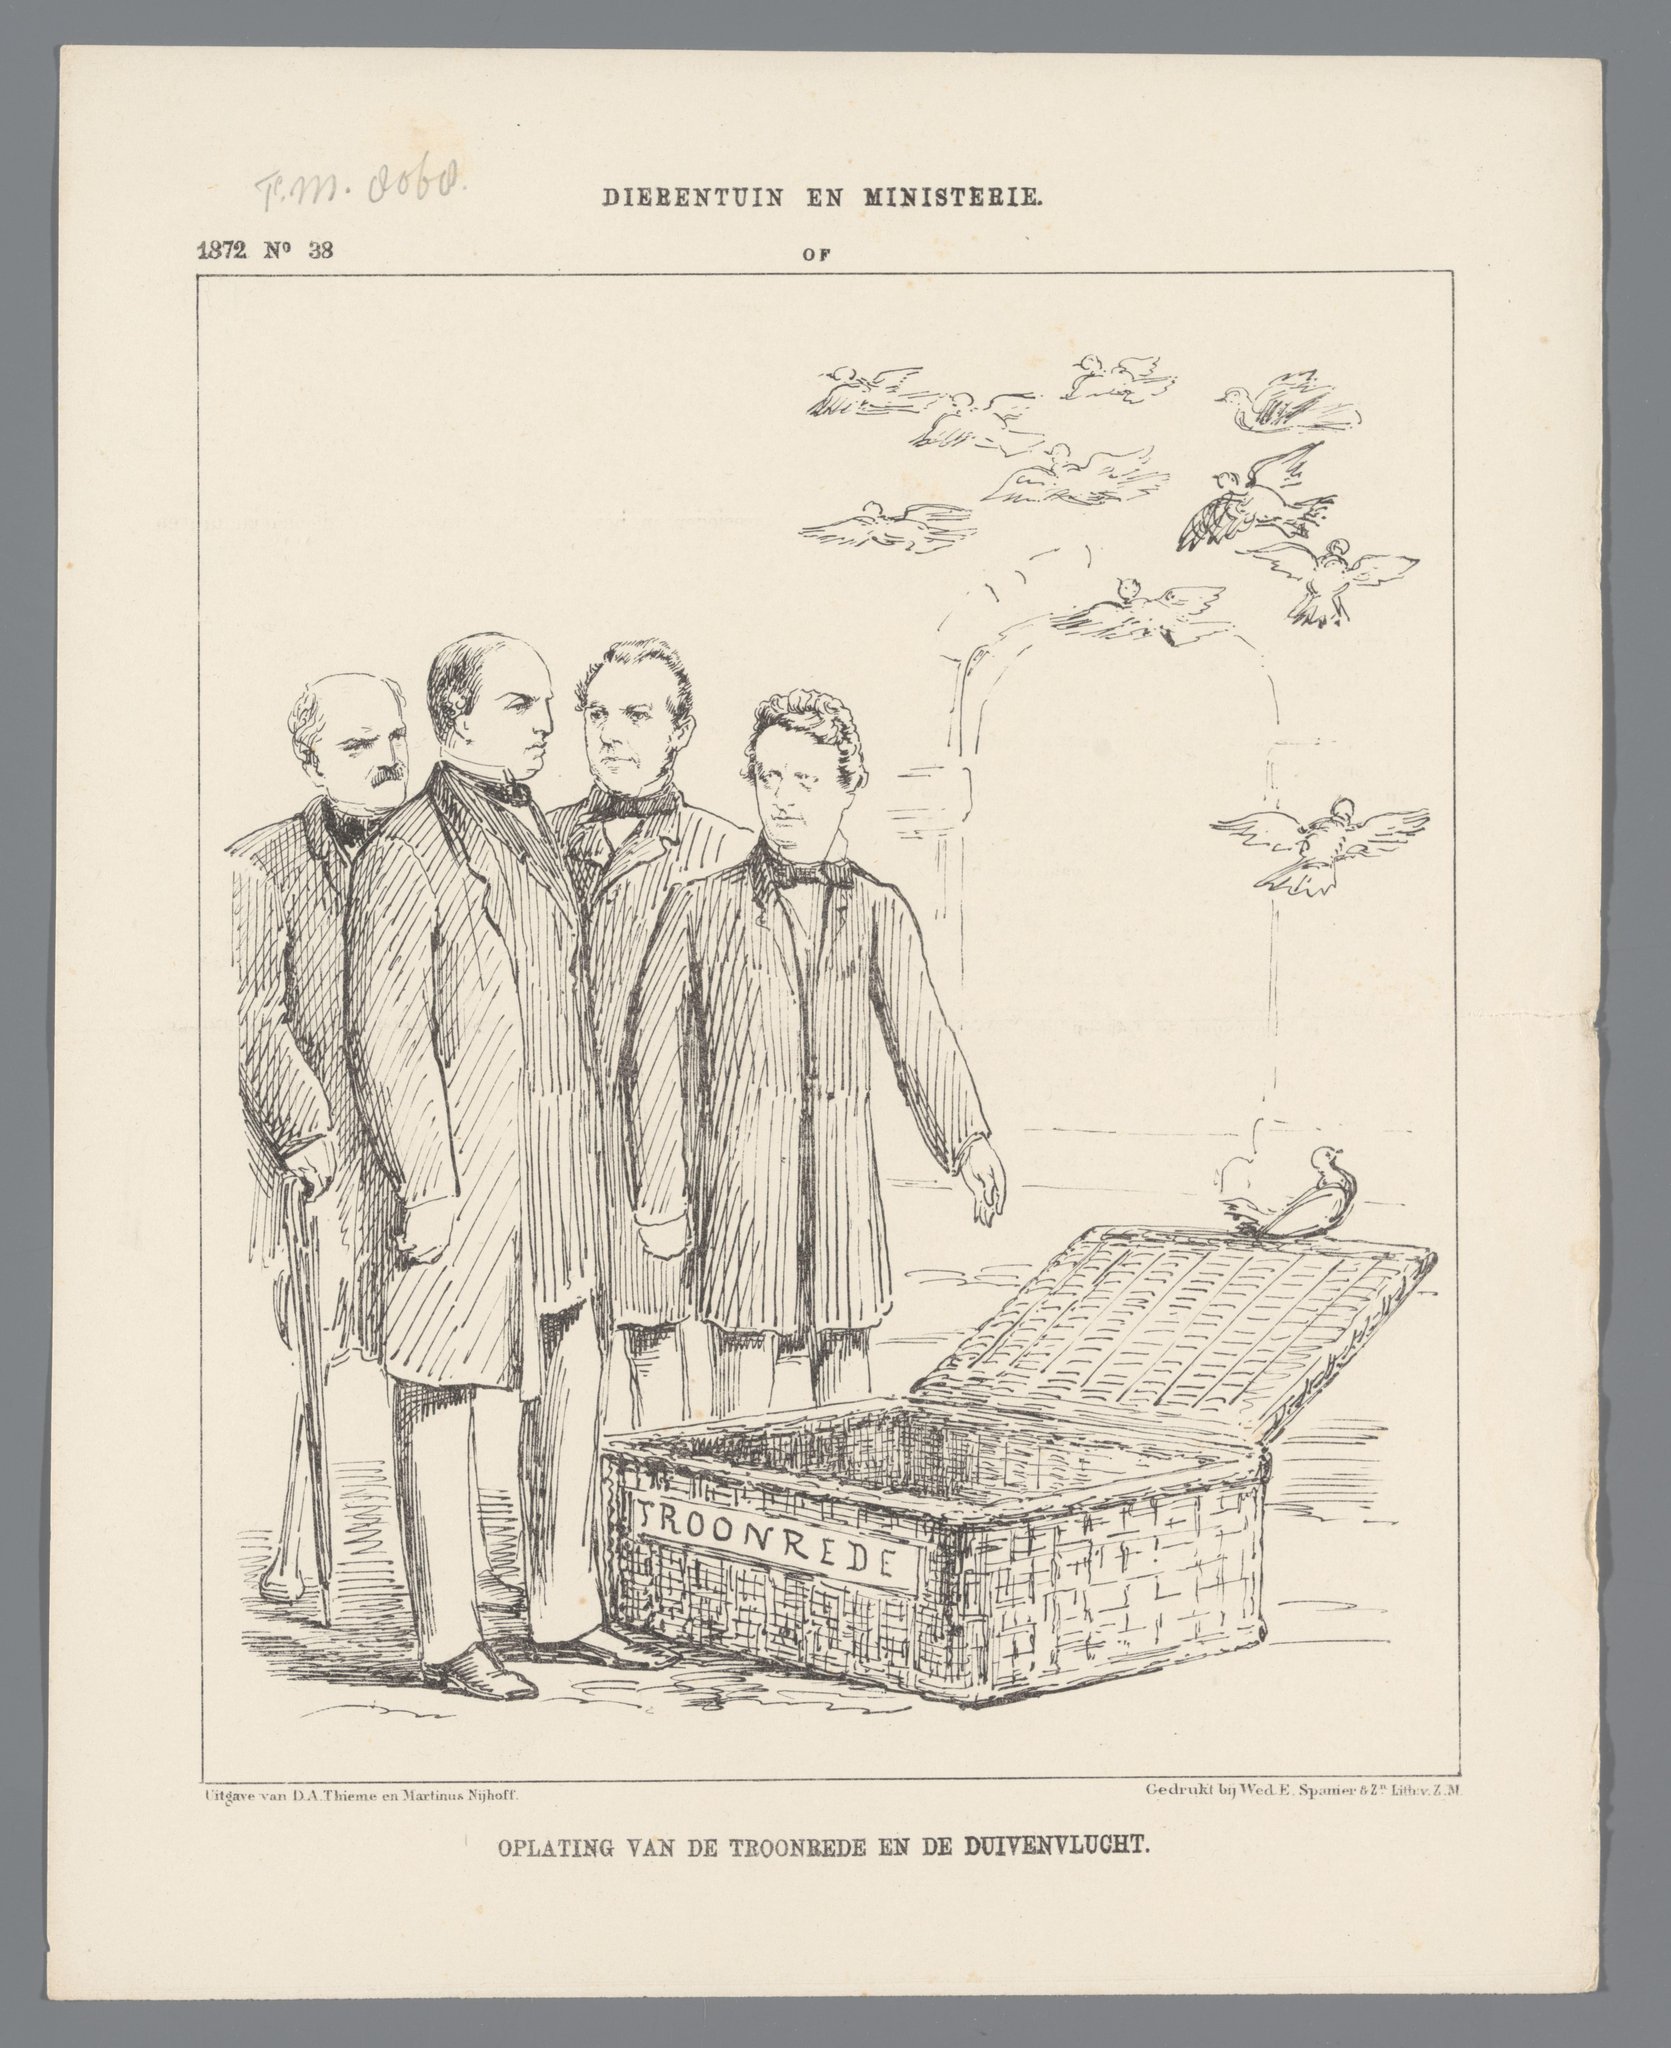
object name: cartoon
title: Dierentuin en Ministerie of Oplating van de troonrede en de duivenvlucht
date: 1872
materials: paper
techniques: lithograph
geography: the hague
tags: politician, pigeons (racing)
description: Spotprent op debatten in de Tweede Kamer over de troonrede en de gelijktijdige duivenwedstrijd. De ministers Fransen van de Putte, Van Limburg Stirum, Geertsema en De Vries Azn. staande bij de mand 'troonrede' waaruit de duiven gevlogen zijn. Plaat verschenen bij het weekblad De Nederlandsche Spectator, nr. 38, 1872.